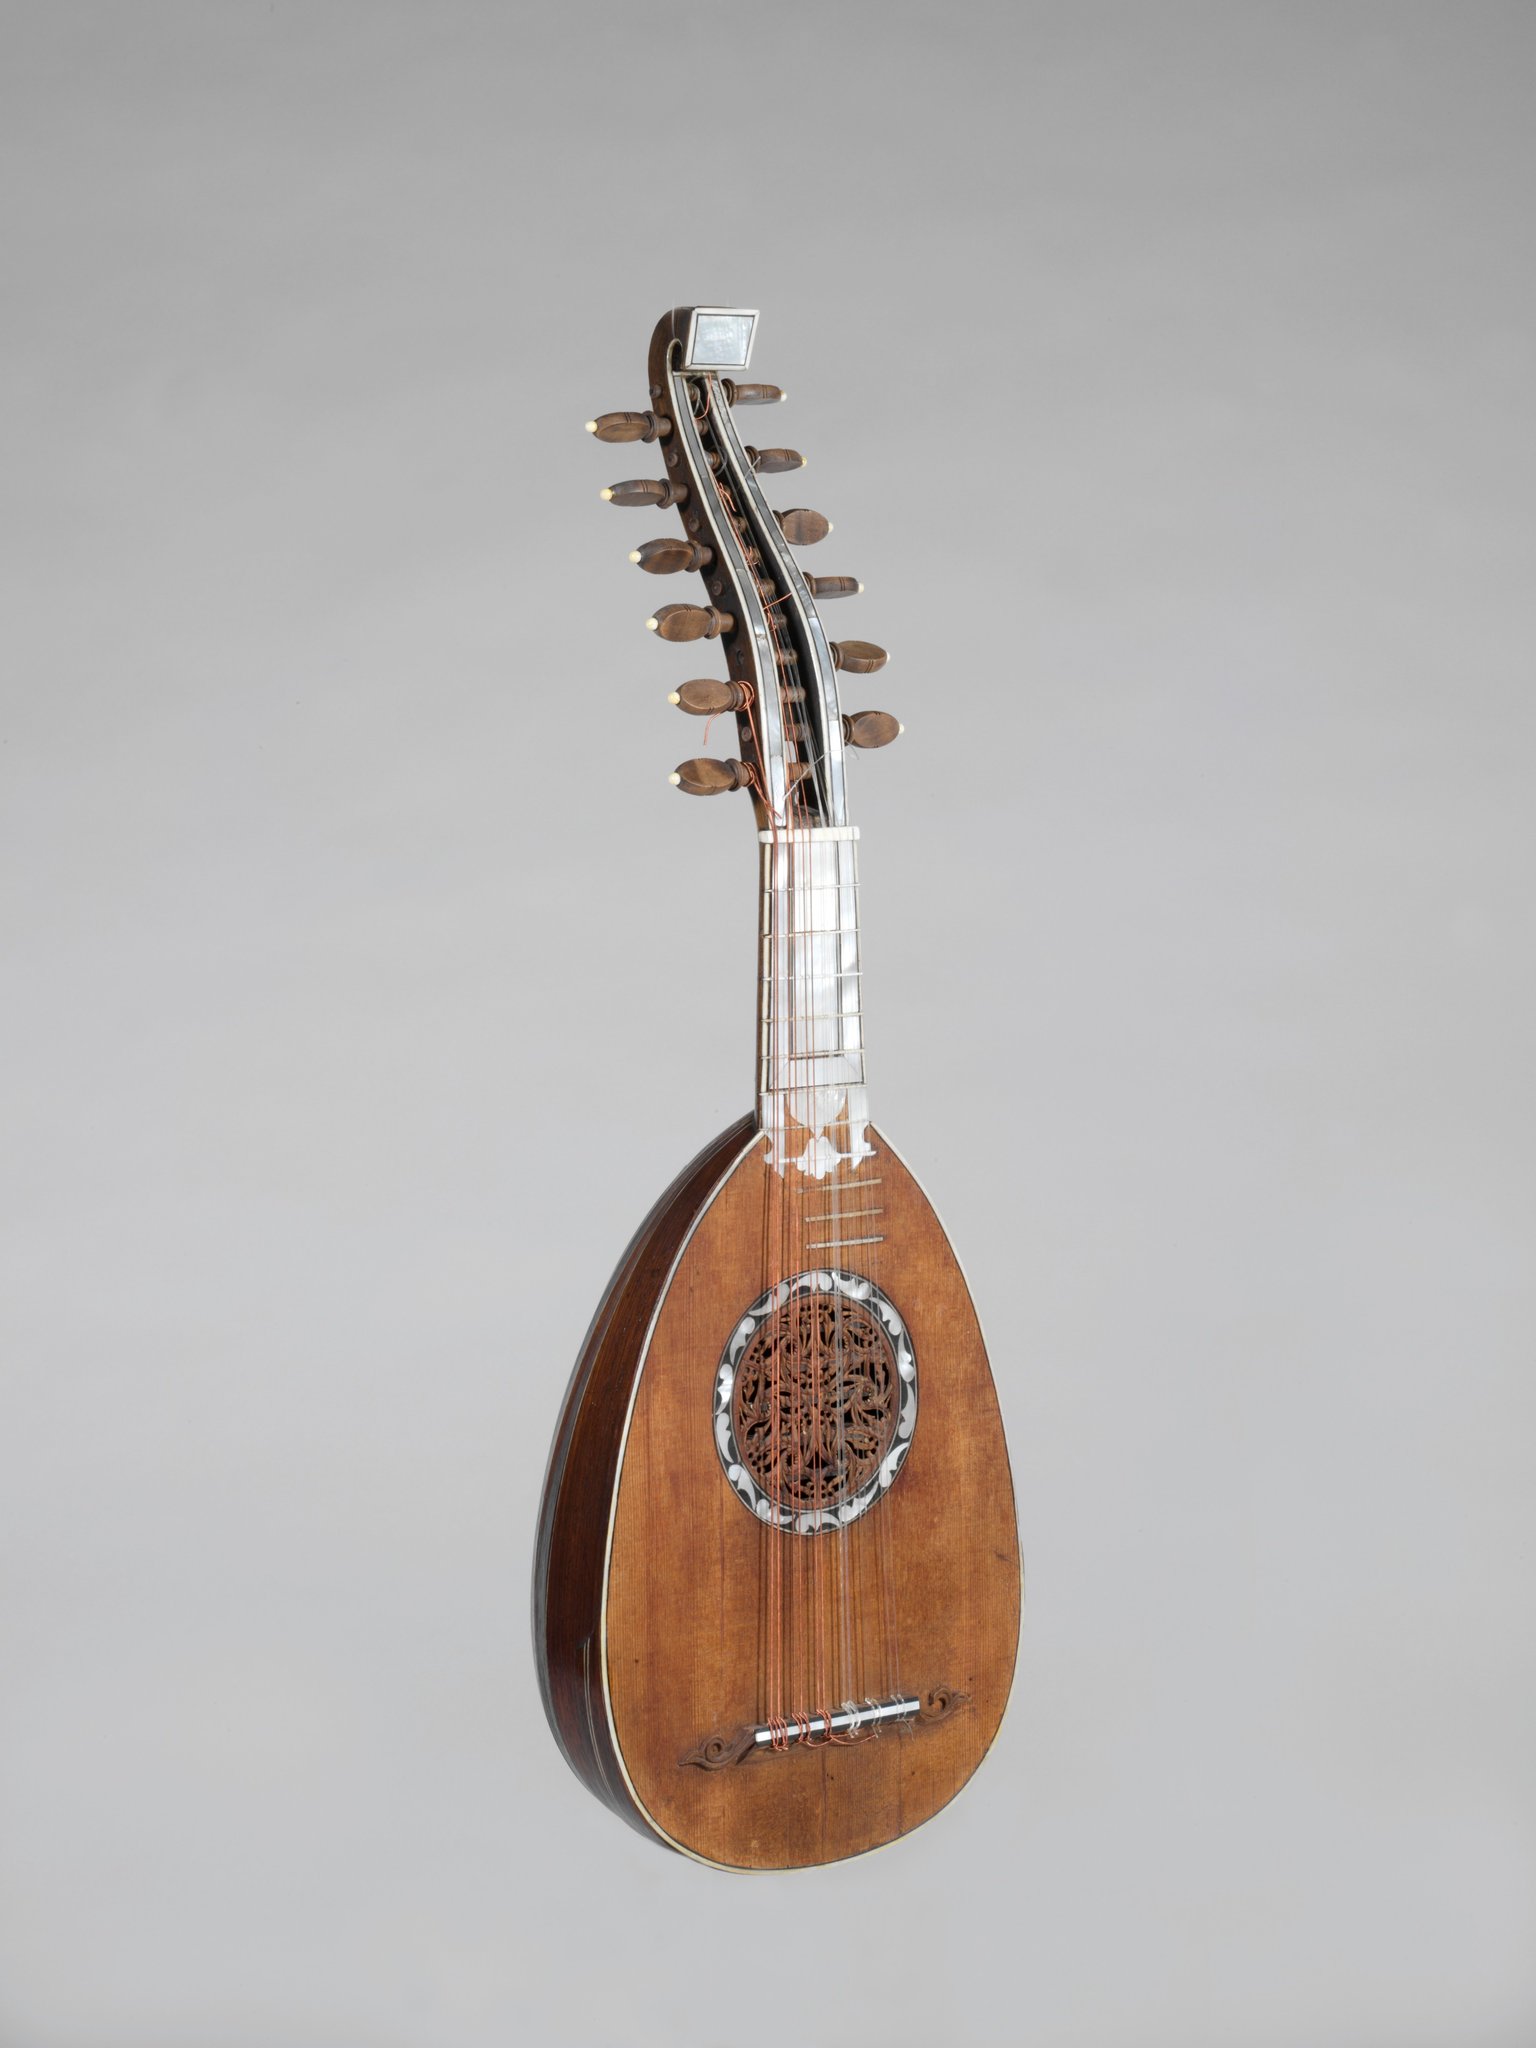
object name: mandolin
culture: italian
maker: giuseppe presbler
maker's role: maker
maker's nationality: german, active italy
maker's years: 1760-1801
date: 1796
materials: bone, mother of pearl, wood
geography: italy